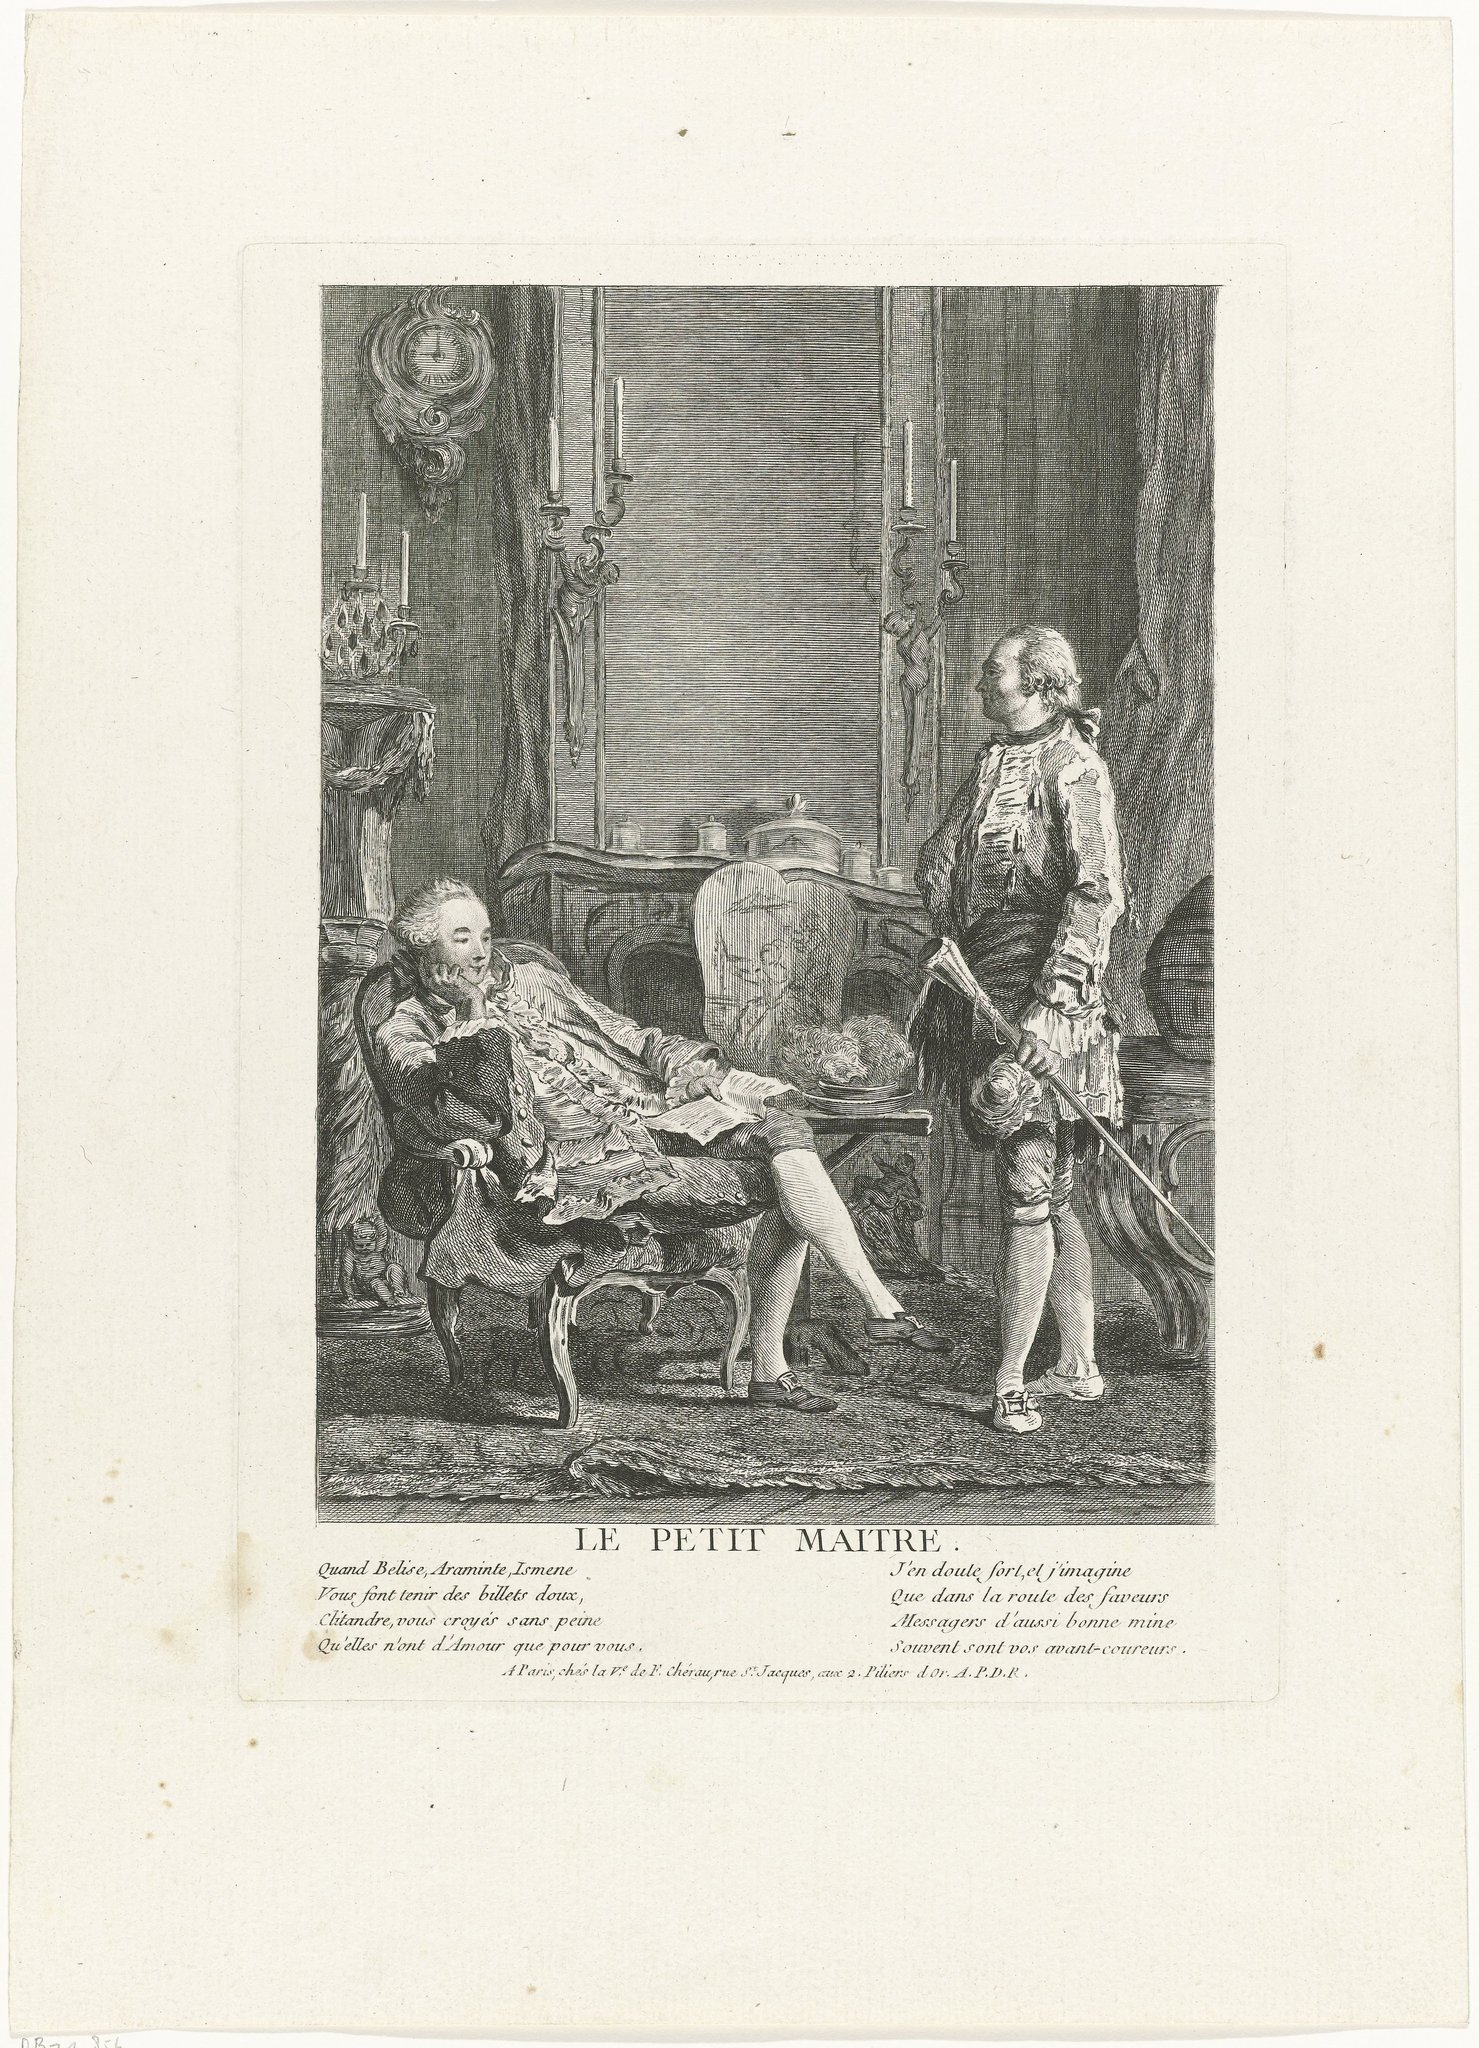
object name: print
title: Le petit Maitre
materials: paper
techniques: etching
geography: france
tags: clothing for the upper part of the body (vest) (+ men's clothes), coat (+ men's clothes), shoes, sandals (+ men's clothes), letter, envelope, trousers, breeches, etc. (breeches) (+ men's clothes), lover with love-letter, walking-stick, staff, cane (+ men's clothes)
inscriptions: poem: ‘Quand Belise, Araminte, Ismene/ Vous font tenir des billets doux, / Chitandre, vous croyés sans peine / Qu'elles n'ont d'Amour que pour vous. / J'en doule fort, et j'imagine / Que dans la route des faveurs / Messagers d'aussi bonne mine / Souvent sont vos avant-coureurs.’, address: ‘A Paris, ches la Ve, de F. Chérau, rue St. Jacques, aux 2. Piliers d'Or A.P.D.R.’, title: ‘LE PETIT MAITRE’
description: In een vertrek in rococo-stijl zit een elegant geklede jongeman, een zogenoemde 'petit maitre", in een leunstoel, een liefdesbrief in de hand. Voor hem staat een heer met staartpruik, ...stok in de linkerhand. Met 2 x 4 regels Frans vers.